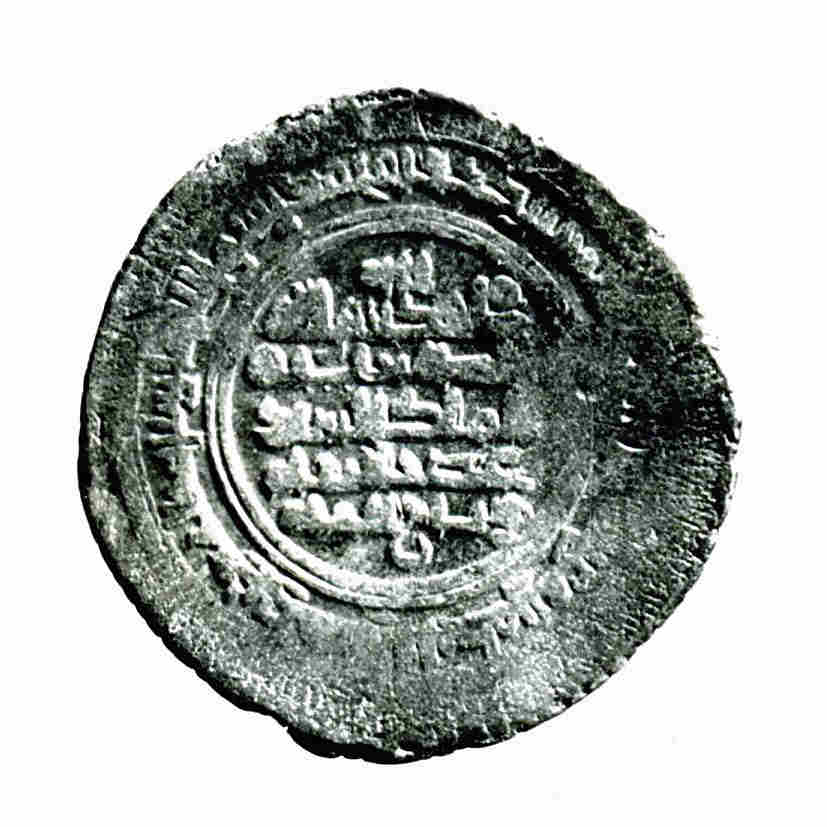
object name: coin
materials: silver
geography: iran